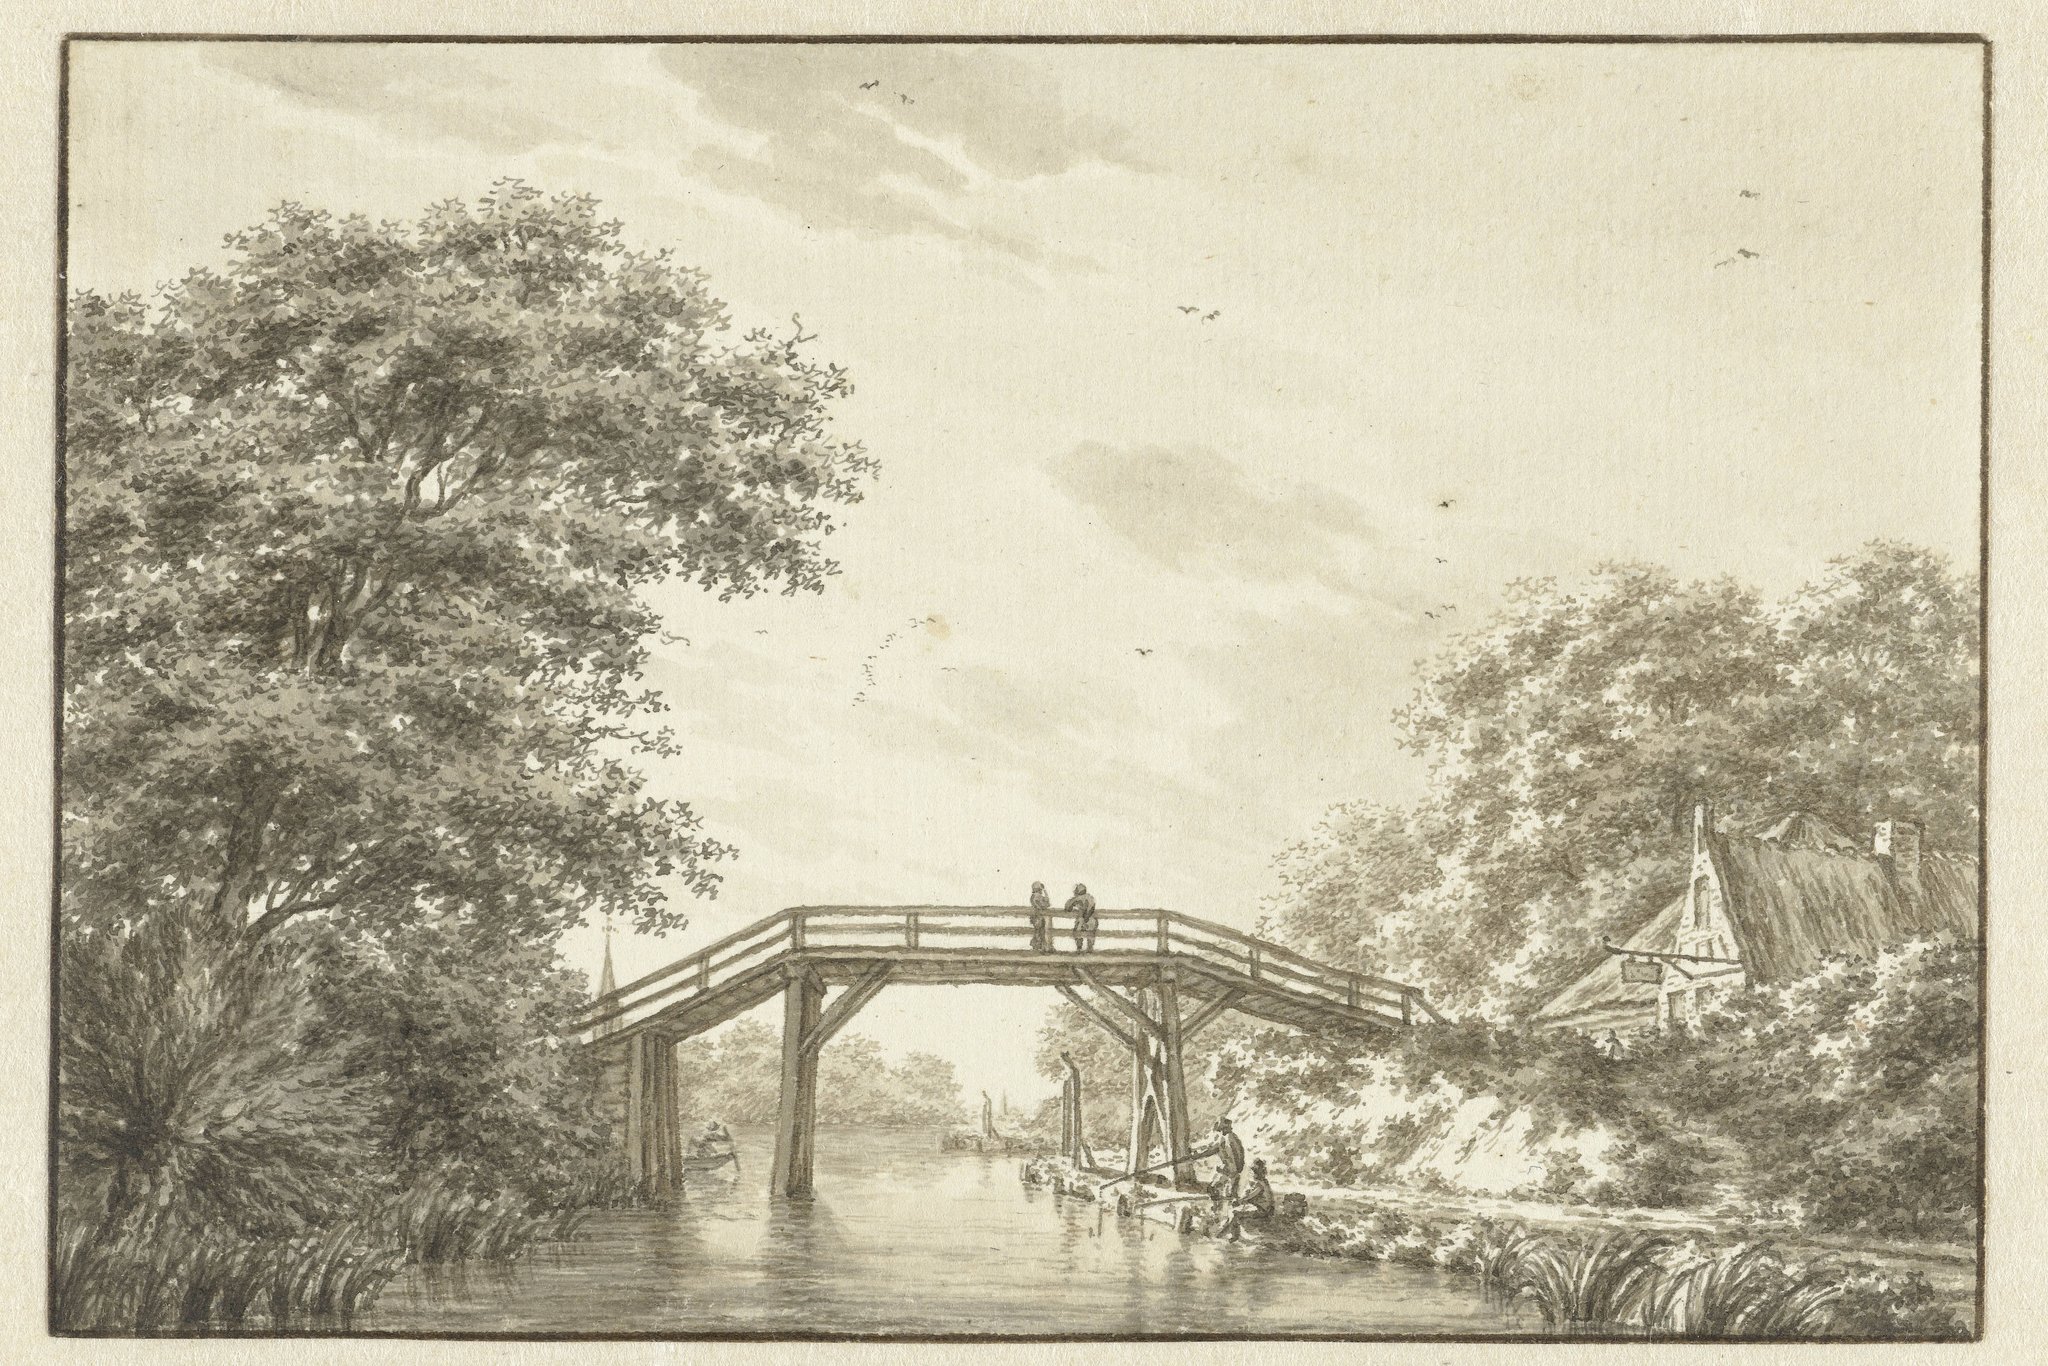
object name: drawing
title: Landschap met hoge brug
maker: jacob cats (1741-1799)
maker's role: draughtsman, print maker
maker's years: 1741-1799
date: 1770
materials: ink, paper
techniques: brush, pen